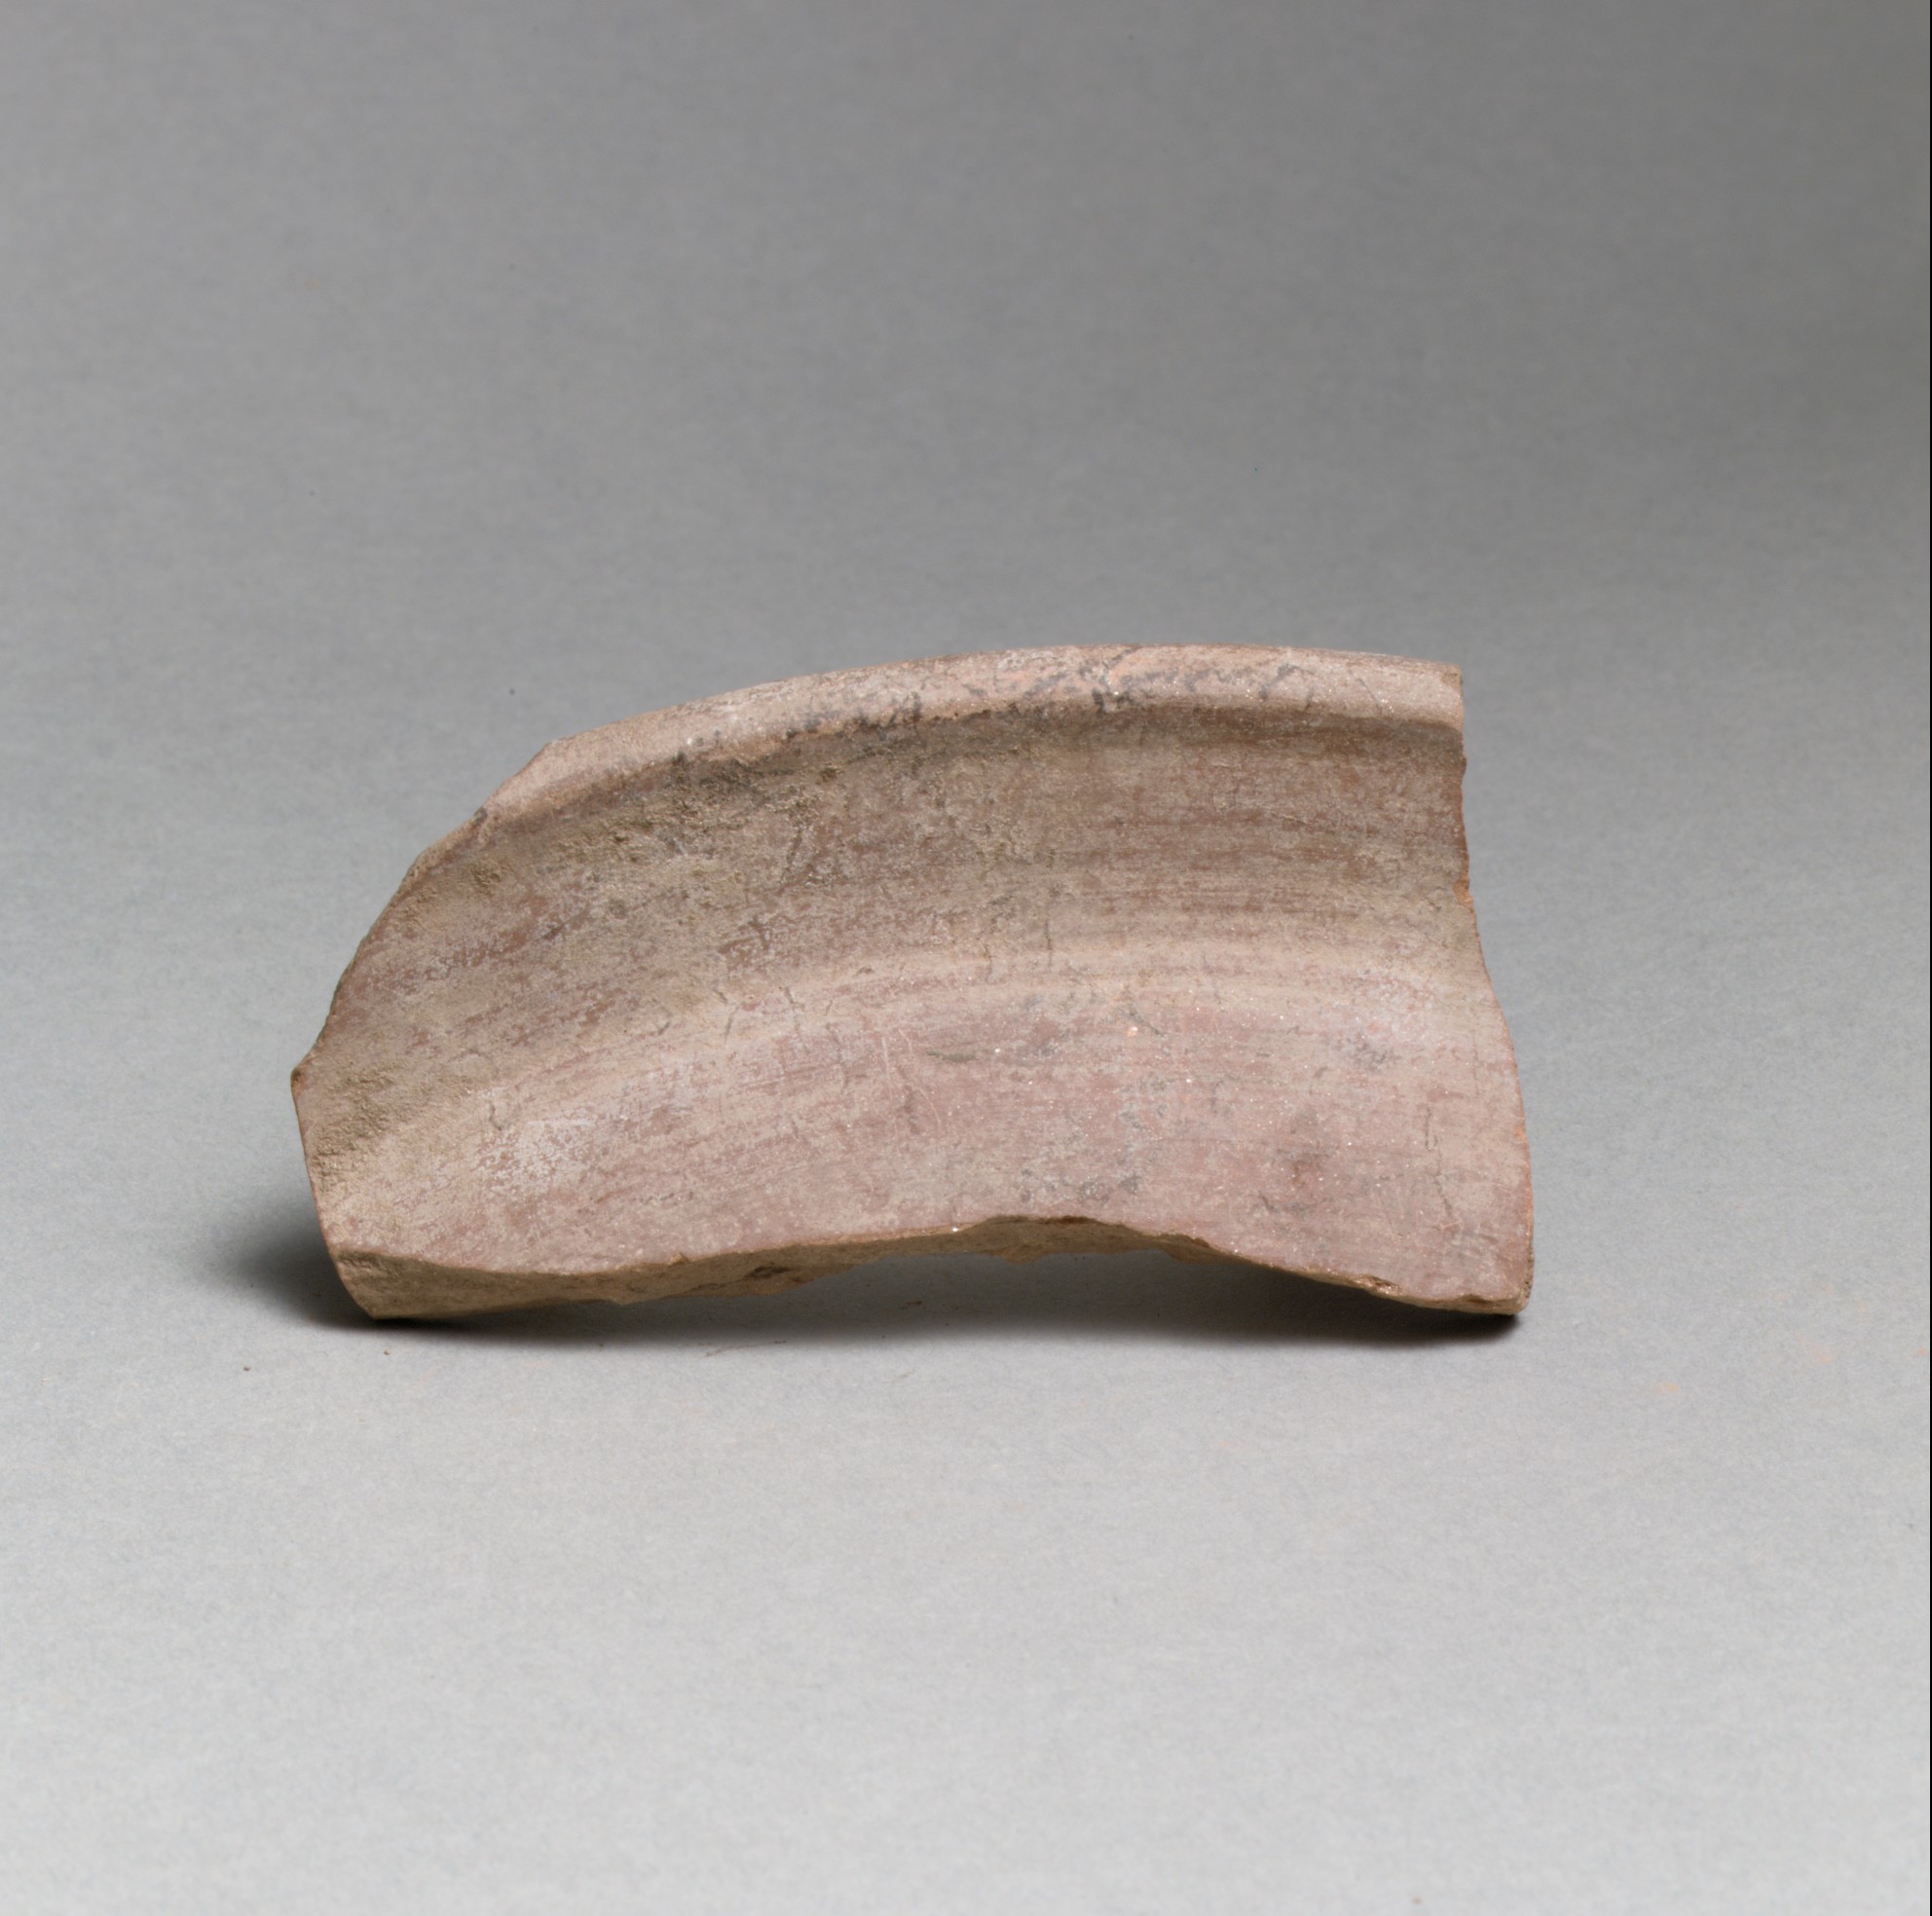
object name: vase fragment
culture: greek or lydian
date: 1050-700 BCE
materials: terracotta